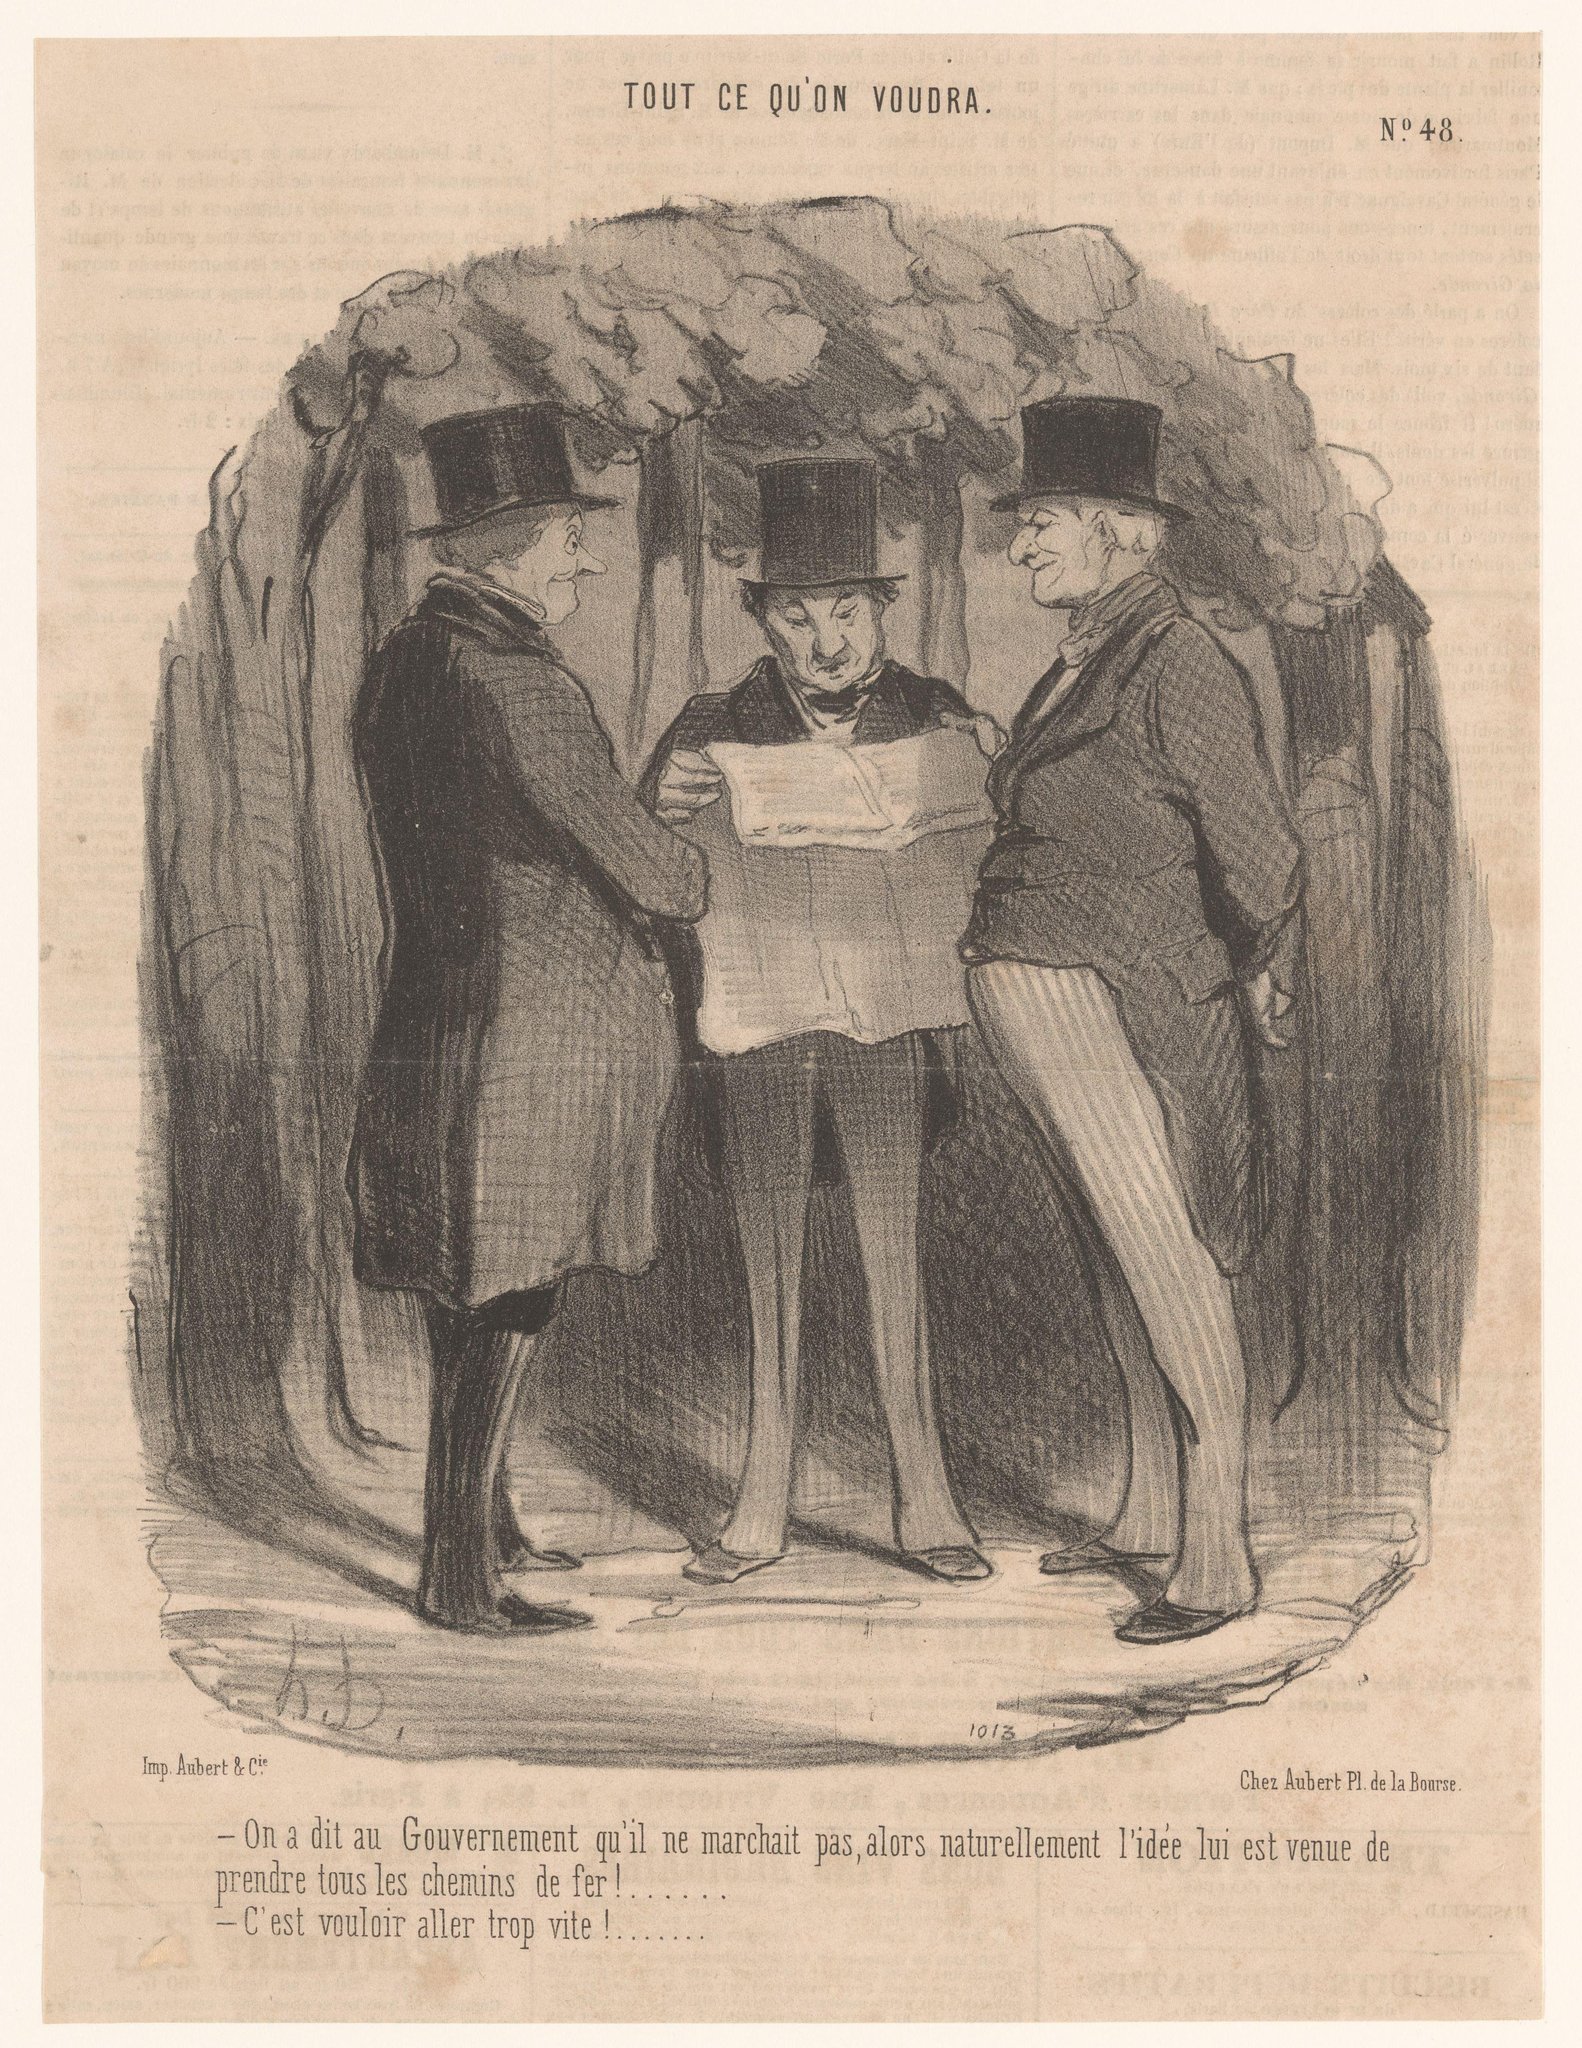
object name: cartoon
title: Drie mannen praten over een krantenbericht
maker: honoré daumier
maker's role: draughtsman, painter, print maker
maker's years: 1808-1879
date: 1848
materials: paper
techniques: lithograph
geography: paris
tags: caricatures (human types), newspaper, news-sheet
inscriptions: collector's mark: Lugt 2228a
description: Prent gebruikt voor: Le Charivari, 5 juli 1848.